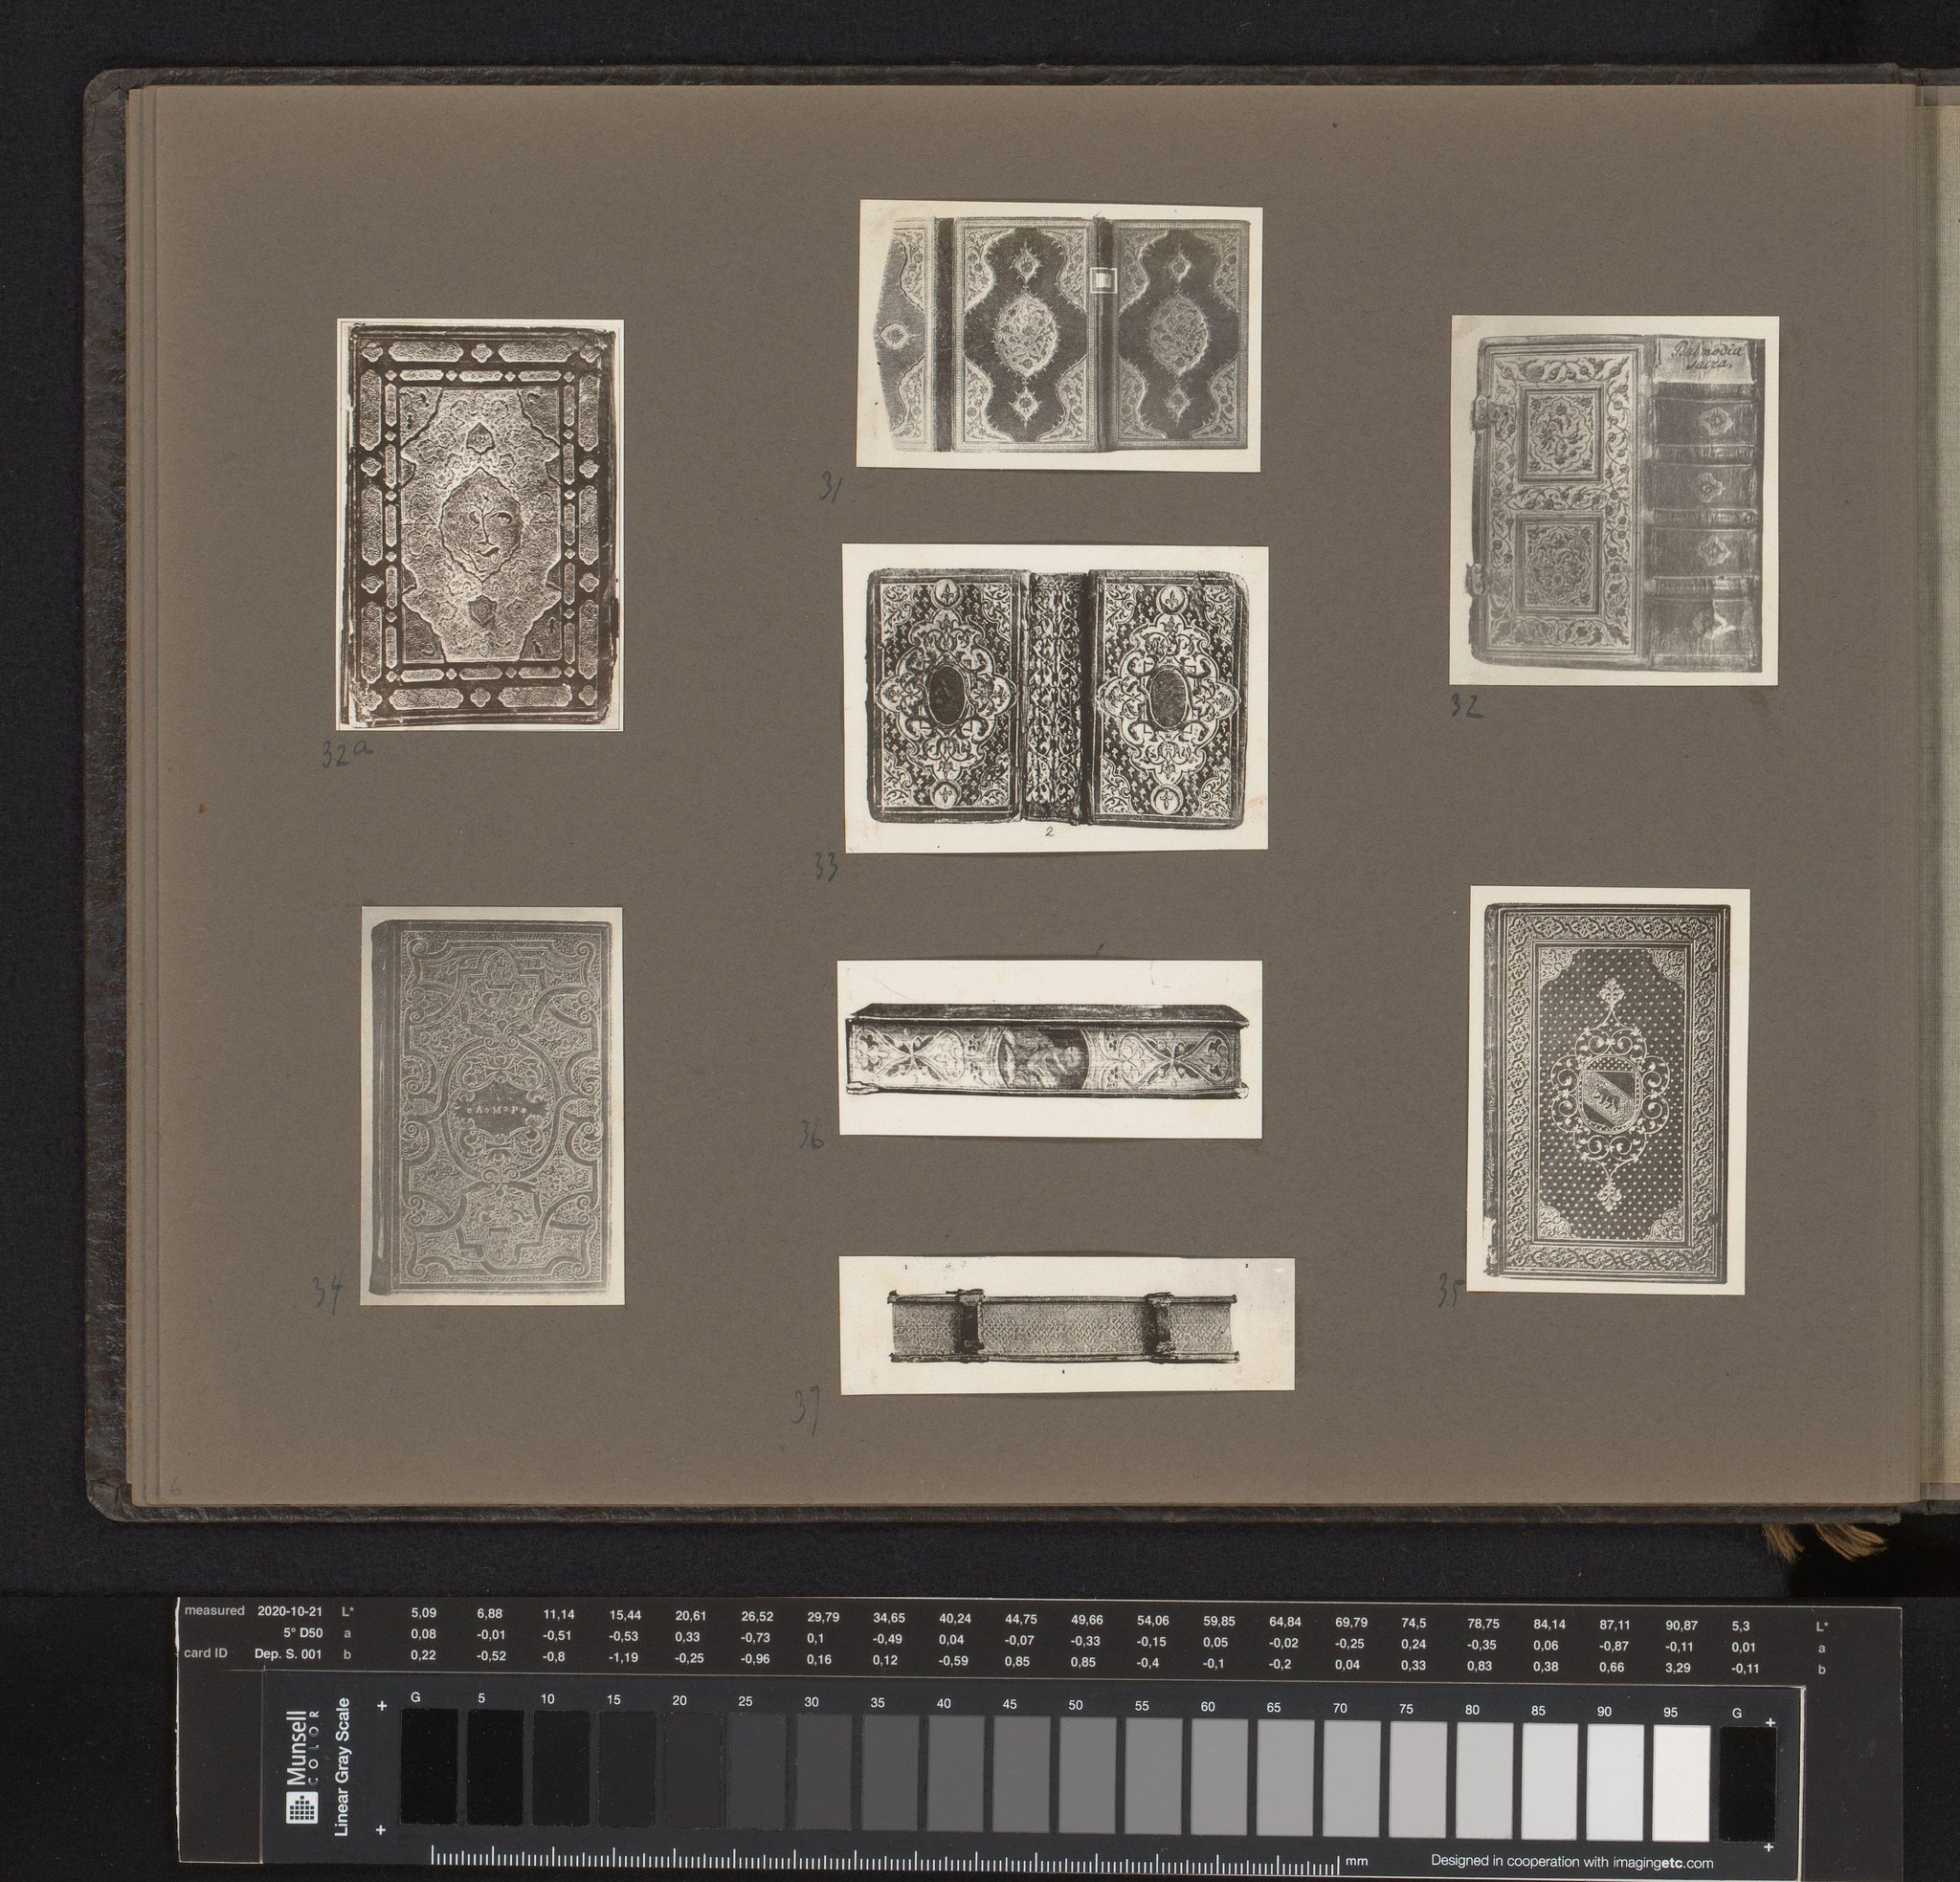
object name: photograph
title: Acht boekbanden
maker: Anonymous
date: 1920-1940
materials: paper, photographic support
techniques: gelatin silver print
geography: netherlands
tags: book with clasps, book-cover, binding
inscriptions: number: ‘31/ 32a - 33 - 32/ 34 - 36 - 35/ 37’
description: Acht boekbanden, waarvan twee opengeslagen en twee op de snee gezien. Deze foto's maken deel uit van een album.